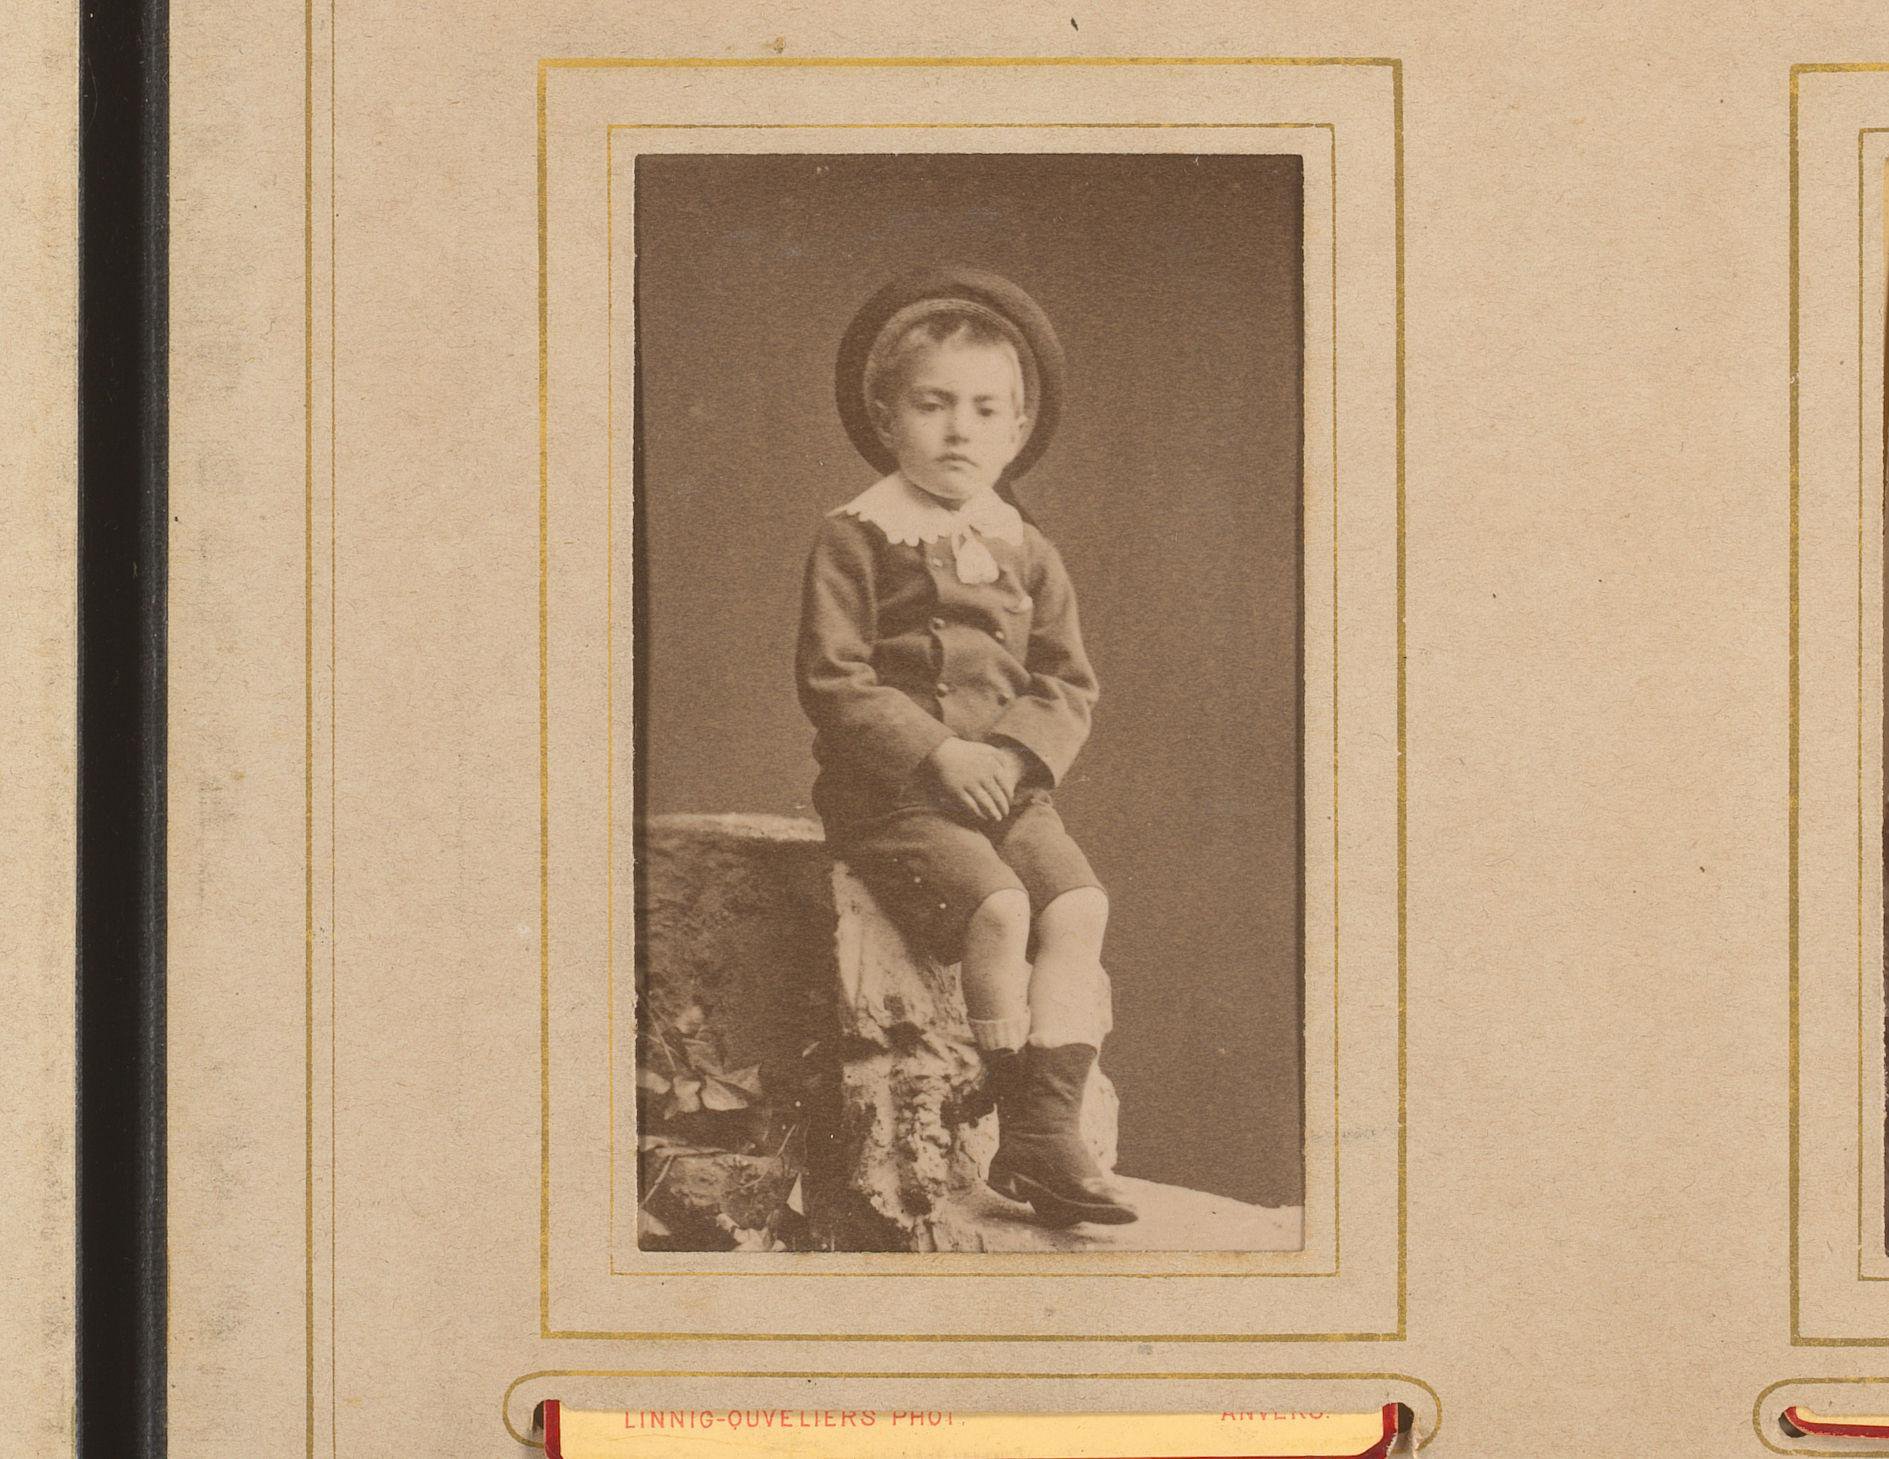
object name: album leaf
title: Portret van een jongen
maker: egide linnig-quveliers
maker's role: fotograaf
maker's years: 1844-1908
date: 1874-1882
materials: cardboard, photographic support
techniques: albumen print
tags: boy (child between toddler and youth), historical persons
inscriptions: name: ‘Linning-Queveliers Phot Anvers’, inscription: ‘Maison Linning-Queveliers/ Photographie/ Rue de la Commune 20/ (...)’